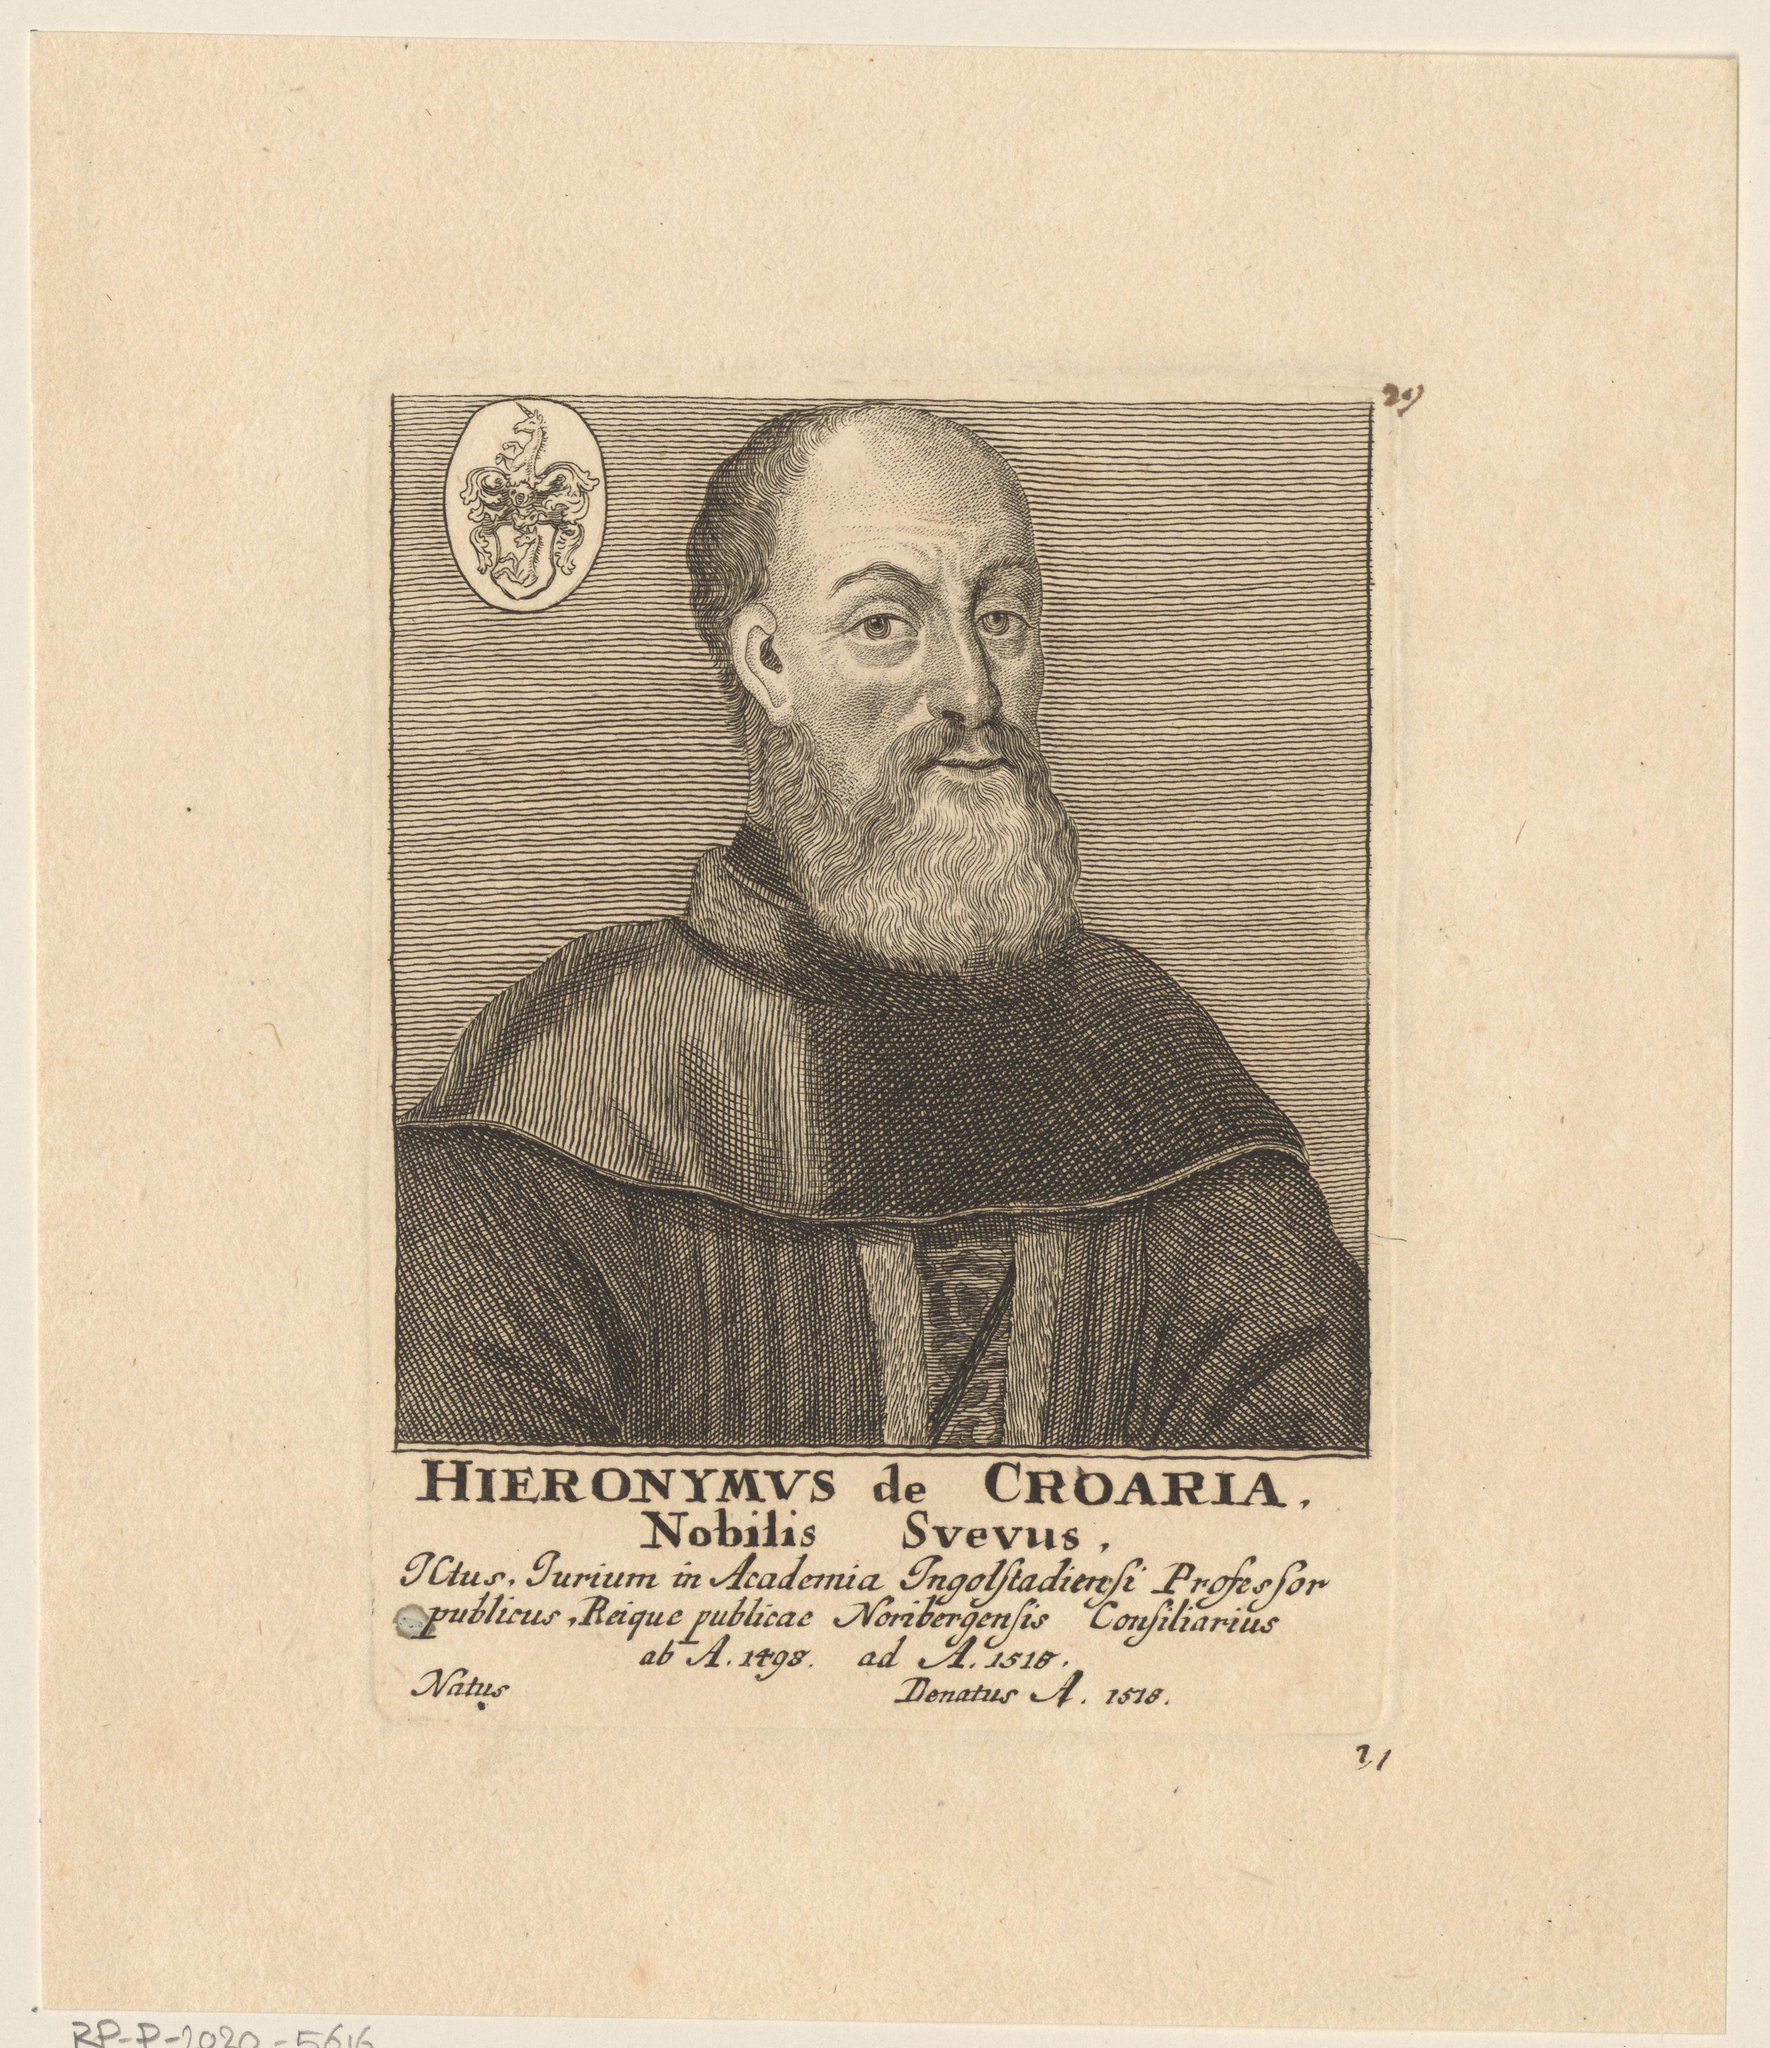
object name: print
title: Portret van Jérôme de Croaria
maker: Anonymous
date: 1725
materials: paper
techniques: engraving, etching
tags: historical persons, armorial bearing, heraldry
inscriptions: : Lugt 2228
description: Prent mogelijk uit: Rothscholtz, Friedrich. Icones virorum omnium ordinum eruditione: omnique item genere et varietate artium de republica litteraria et speciatim de Academiis et Gymnasiis (...). Neurenberg: erven Johann Daniel Tauber, 1725.